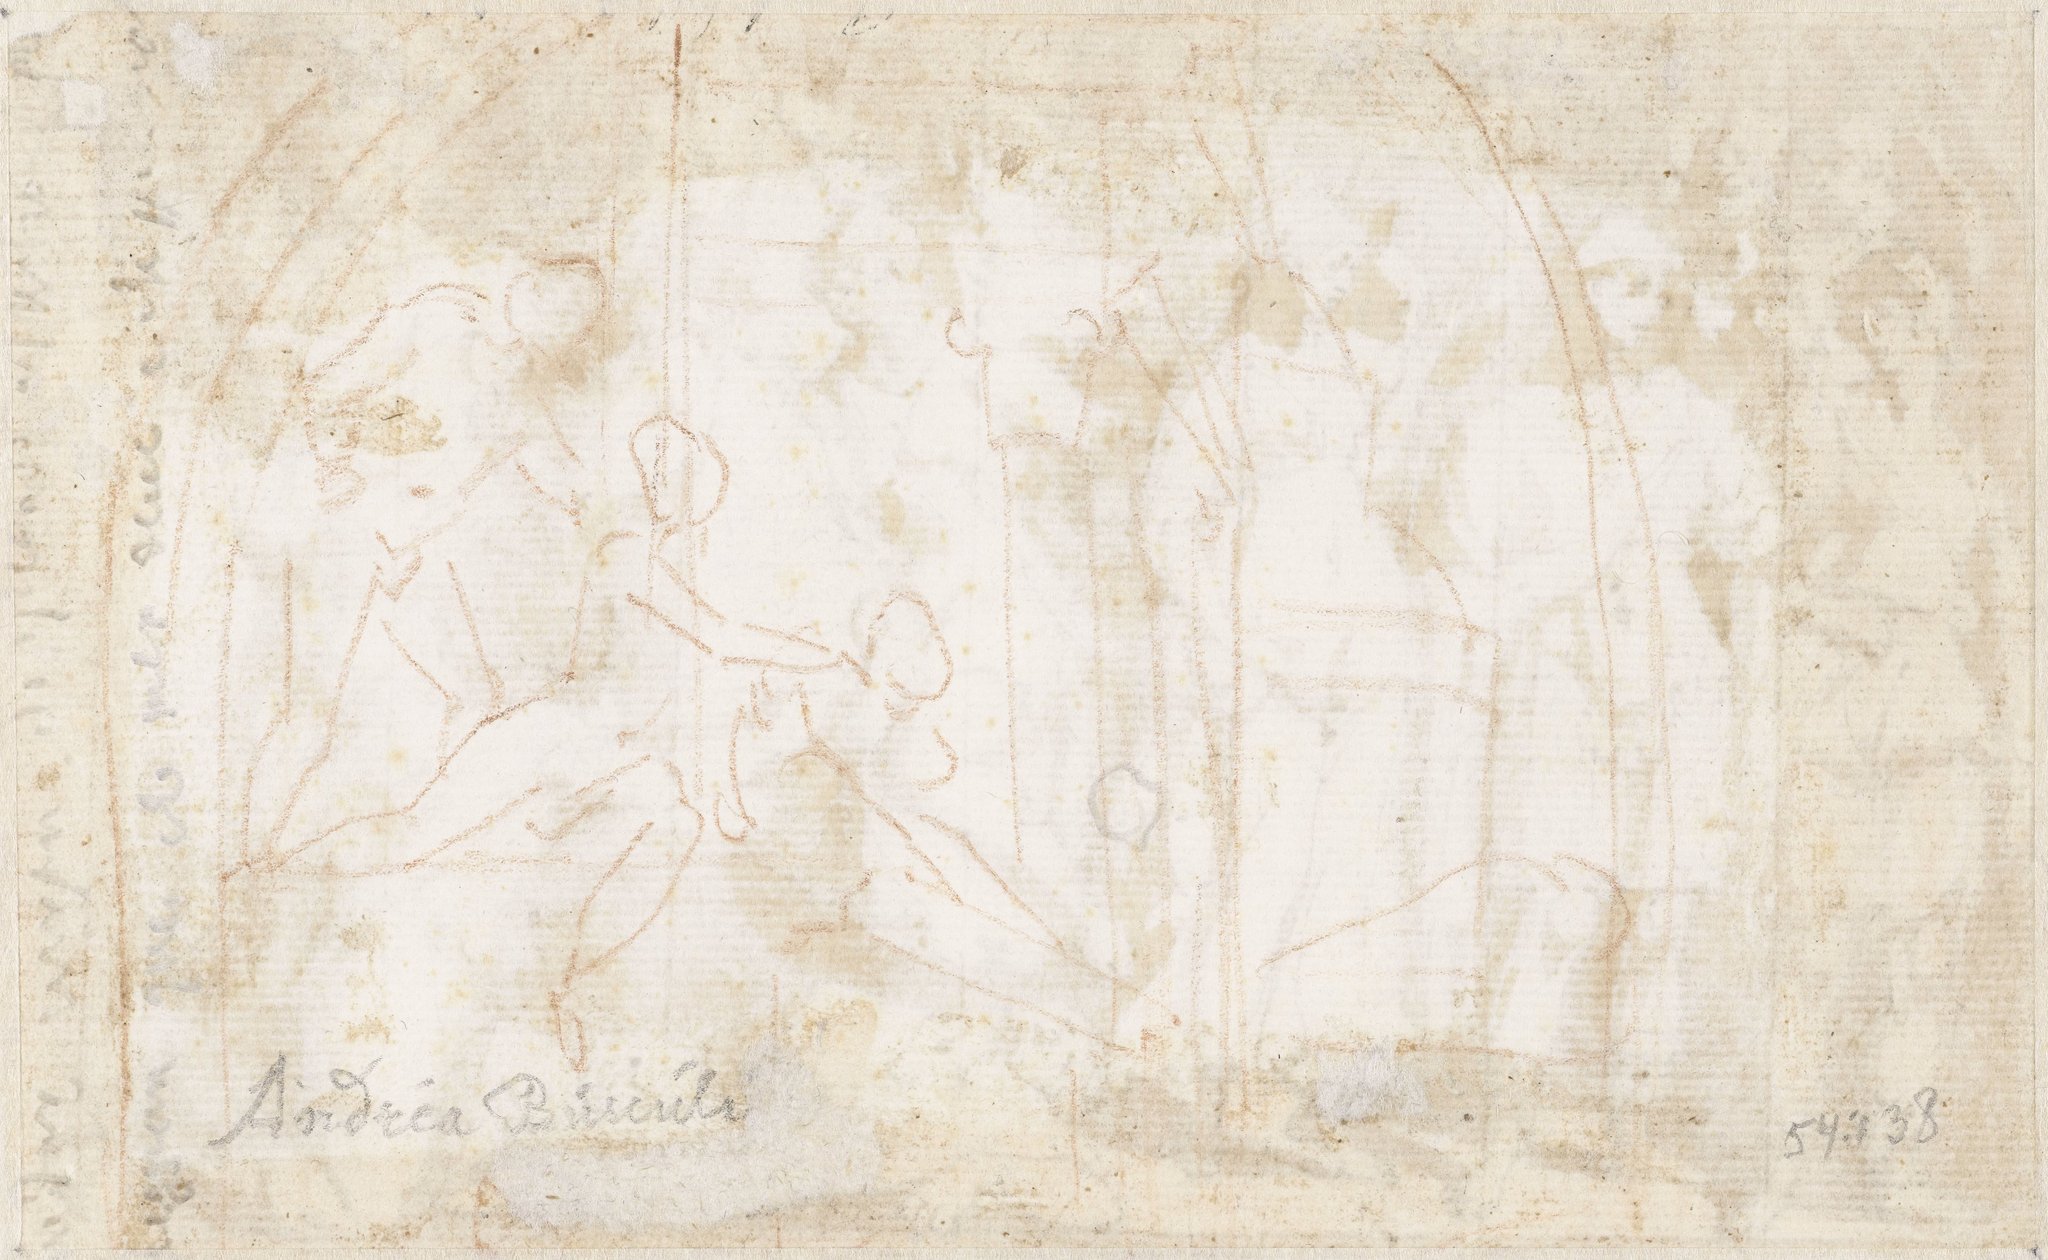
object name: drawing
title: Drie personen bij een basiliek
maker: andrea boscoli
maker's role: draughtsman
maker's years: 1560-1607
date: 1570-1607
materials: chalk, paper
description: Schets naar een 16de-eeuwse lunetschildering.